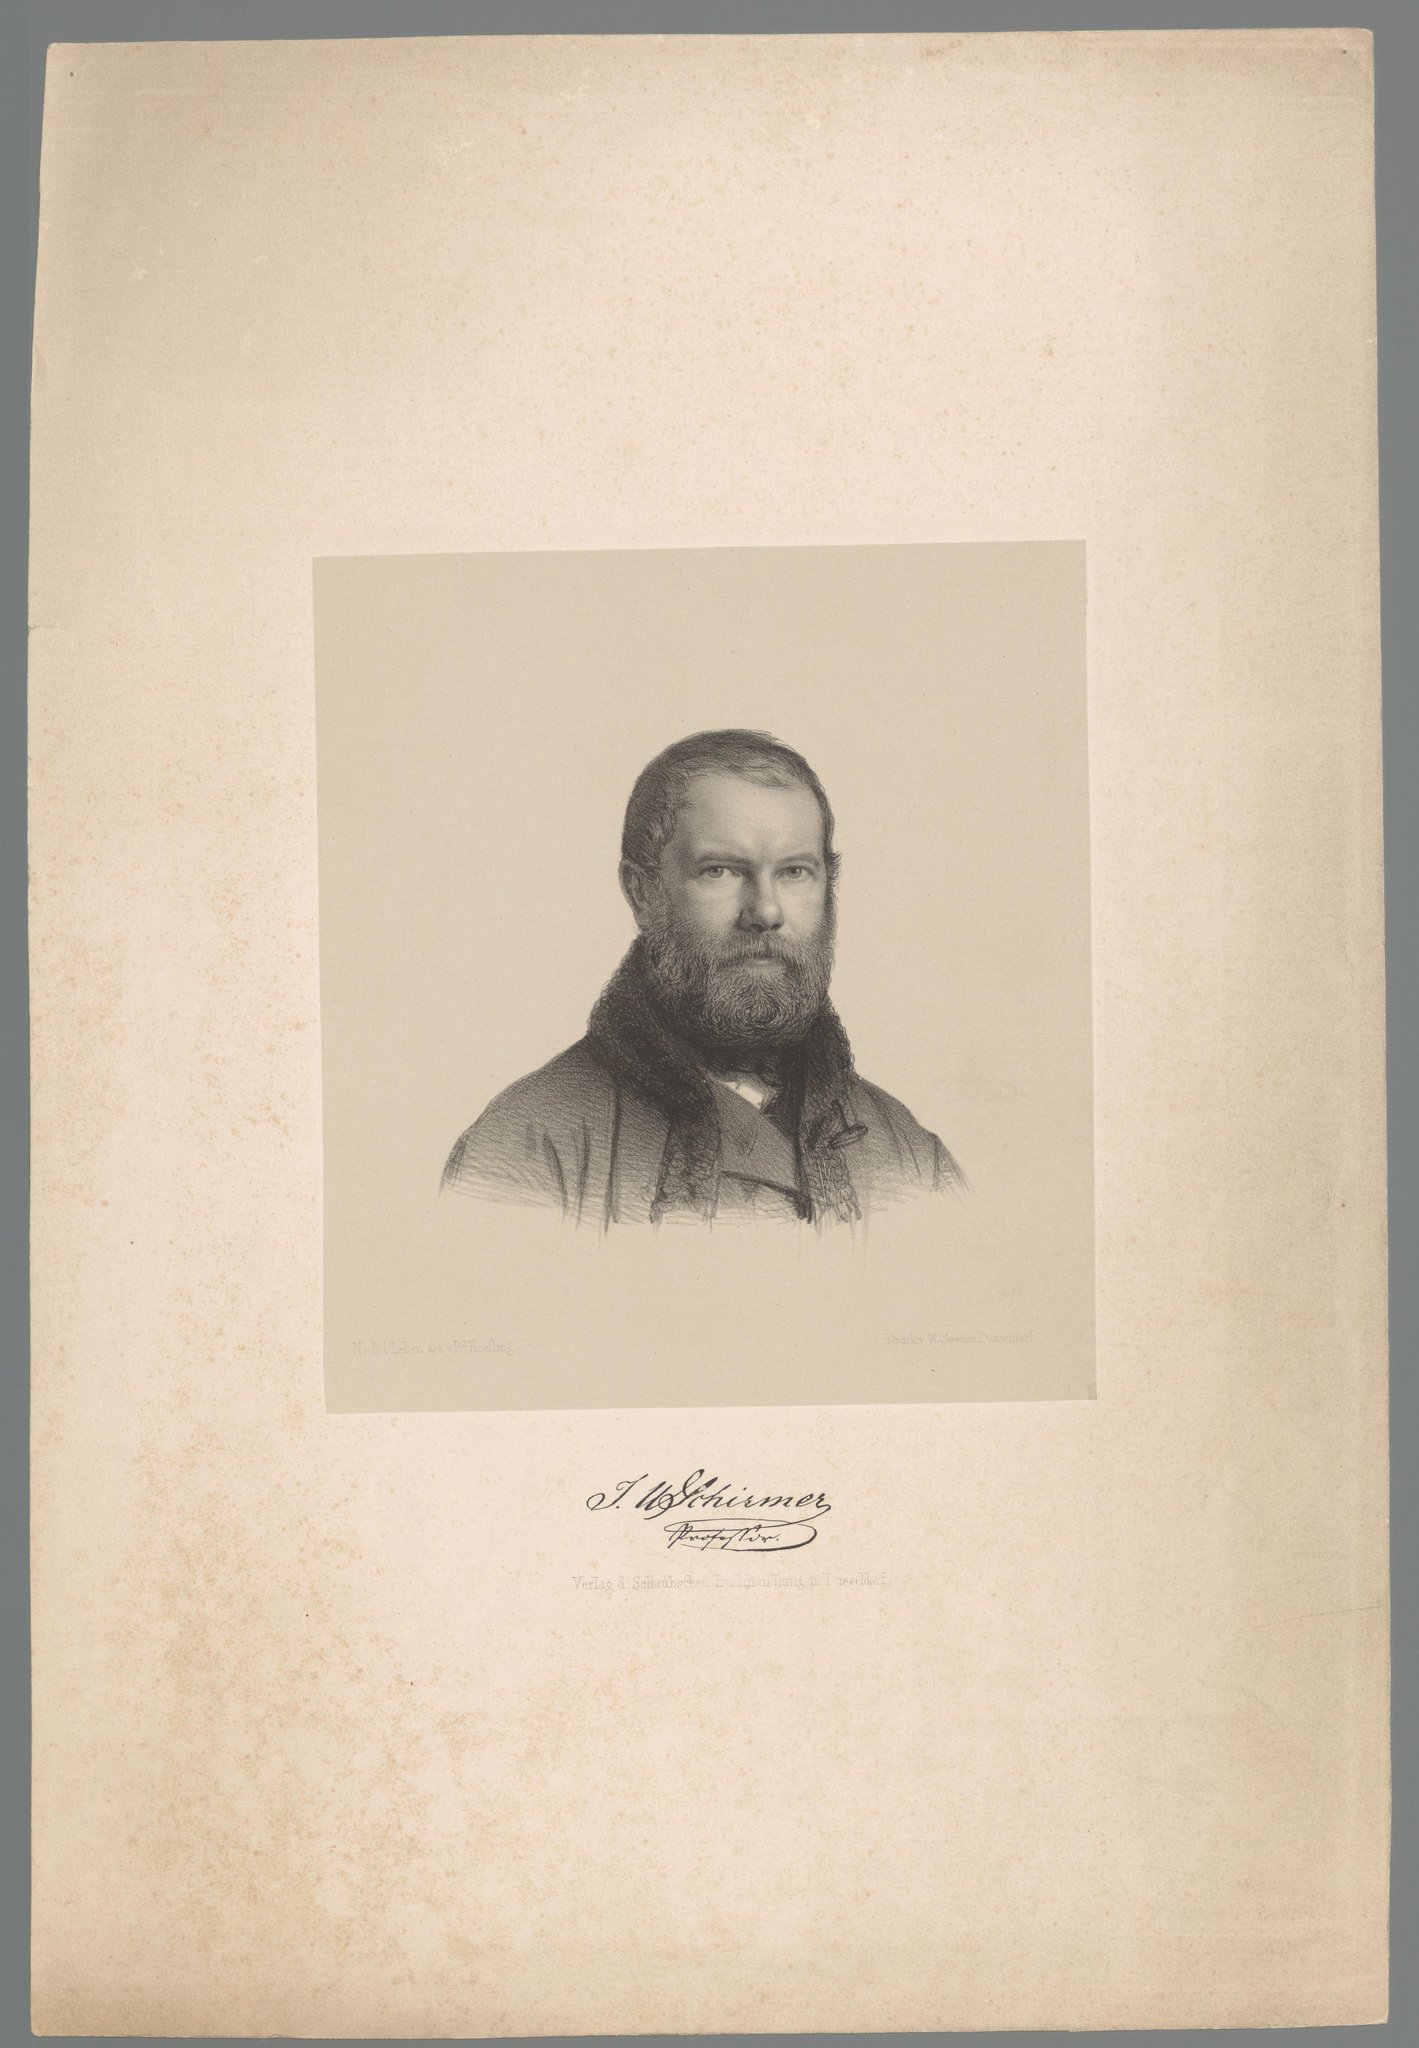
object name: print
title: Portretten van Düsseldorfse kunstenaars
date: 1853-1854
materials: paper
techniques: lithograph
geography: dusseldorf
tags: painter, johann wilhelm schirmer, adult man, historical persons, portrait, self-portrait of artist, beard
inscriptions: collector's mark: Lugt 2228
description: De serie 'Bildnisse Düsseldorfer Künstler' is van 1853-1854 uitgegeven in drie delen met elk vier portretten.